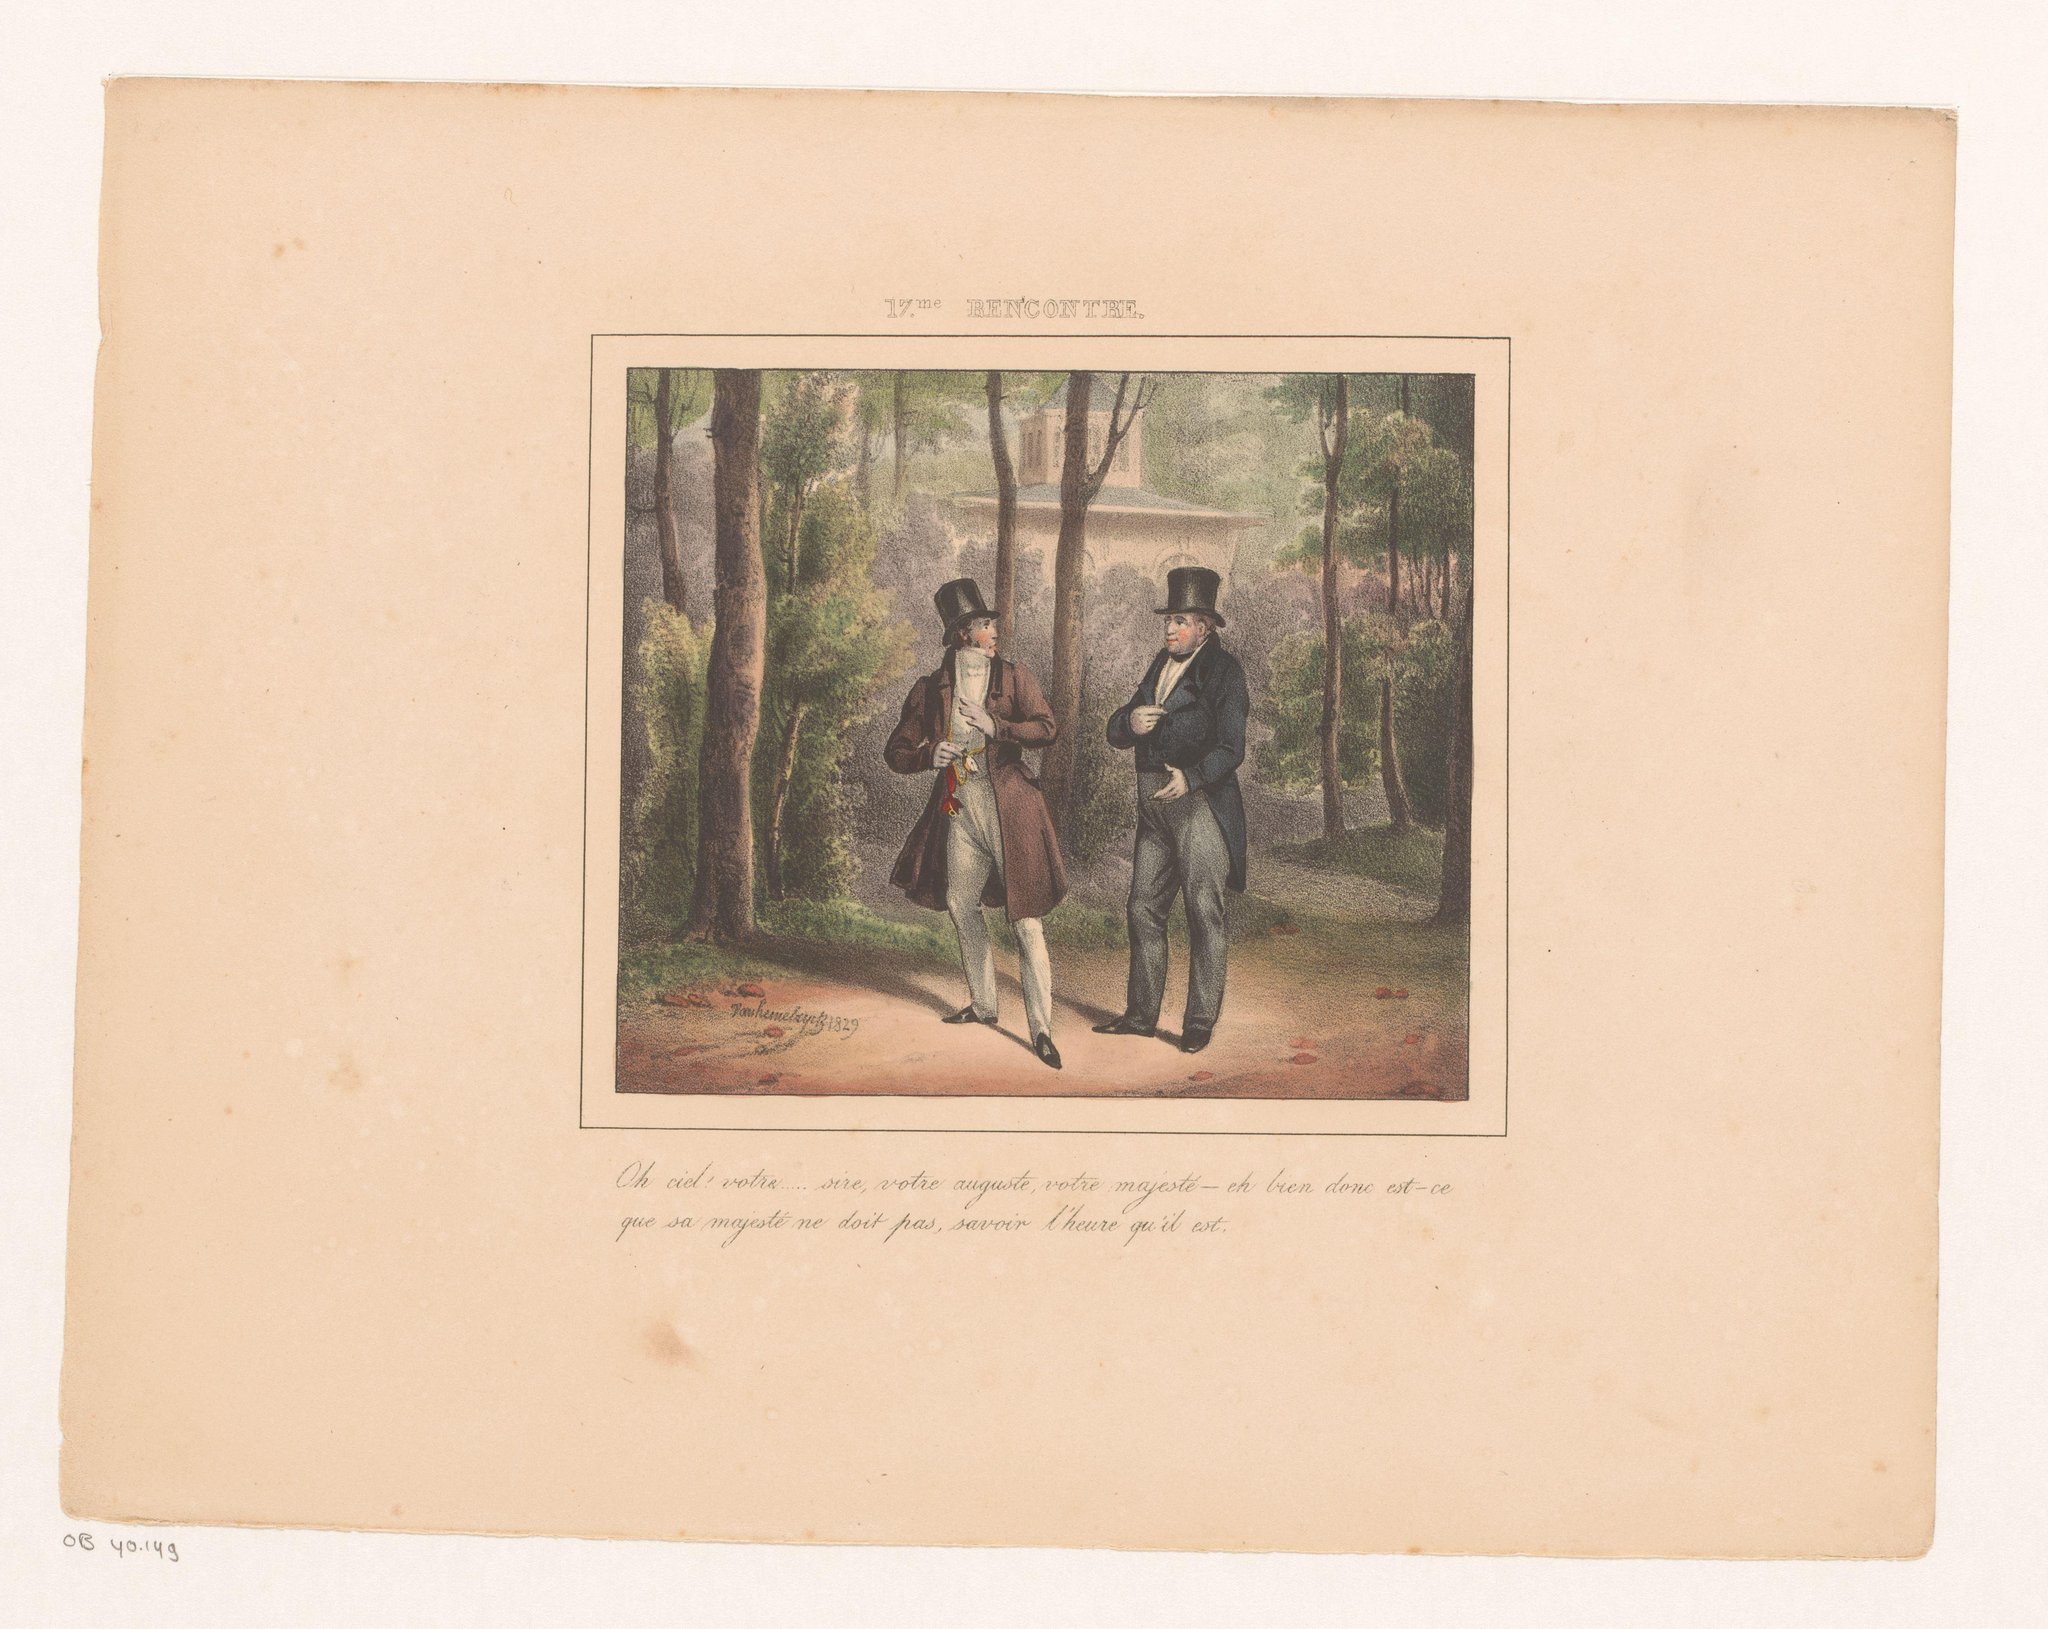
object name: print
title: 17me Rencontre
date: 1829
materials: paper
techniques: hand coloring, lithograph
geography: brussels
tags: the hague, berlin, william i of the netherlands, ruler in informal contact with his subjects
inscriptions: collector's mark: Lugt 2228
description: De koning vraagt in het park aan een wandelaar hoe laat het is. Met tweeregelig onderschrift. Onderdeel van de serie van 24 platen met ontmoetingen met koning Willem I, verschenen onder de titel 'Les rencontres' in 1829-1830.